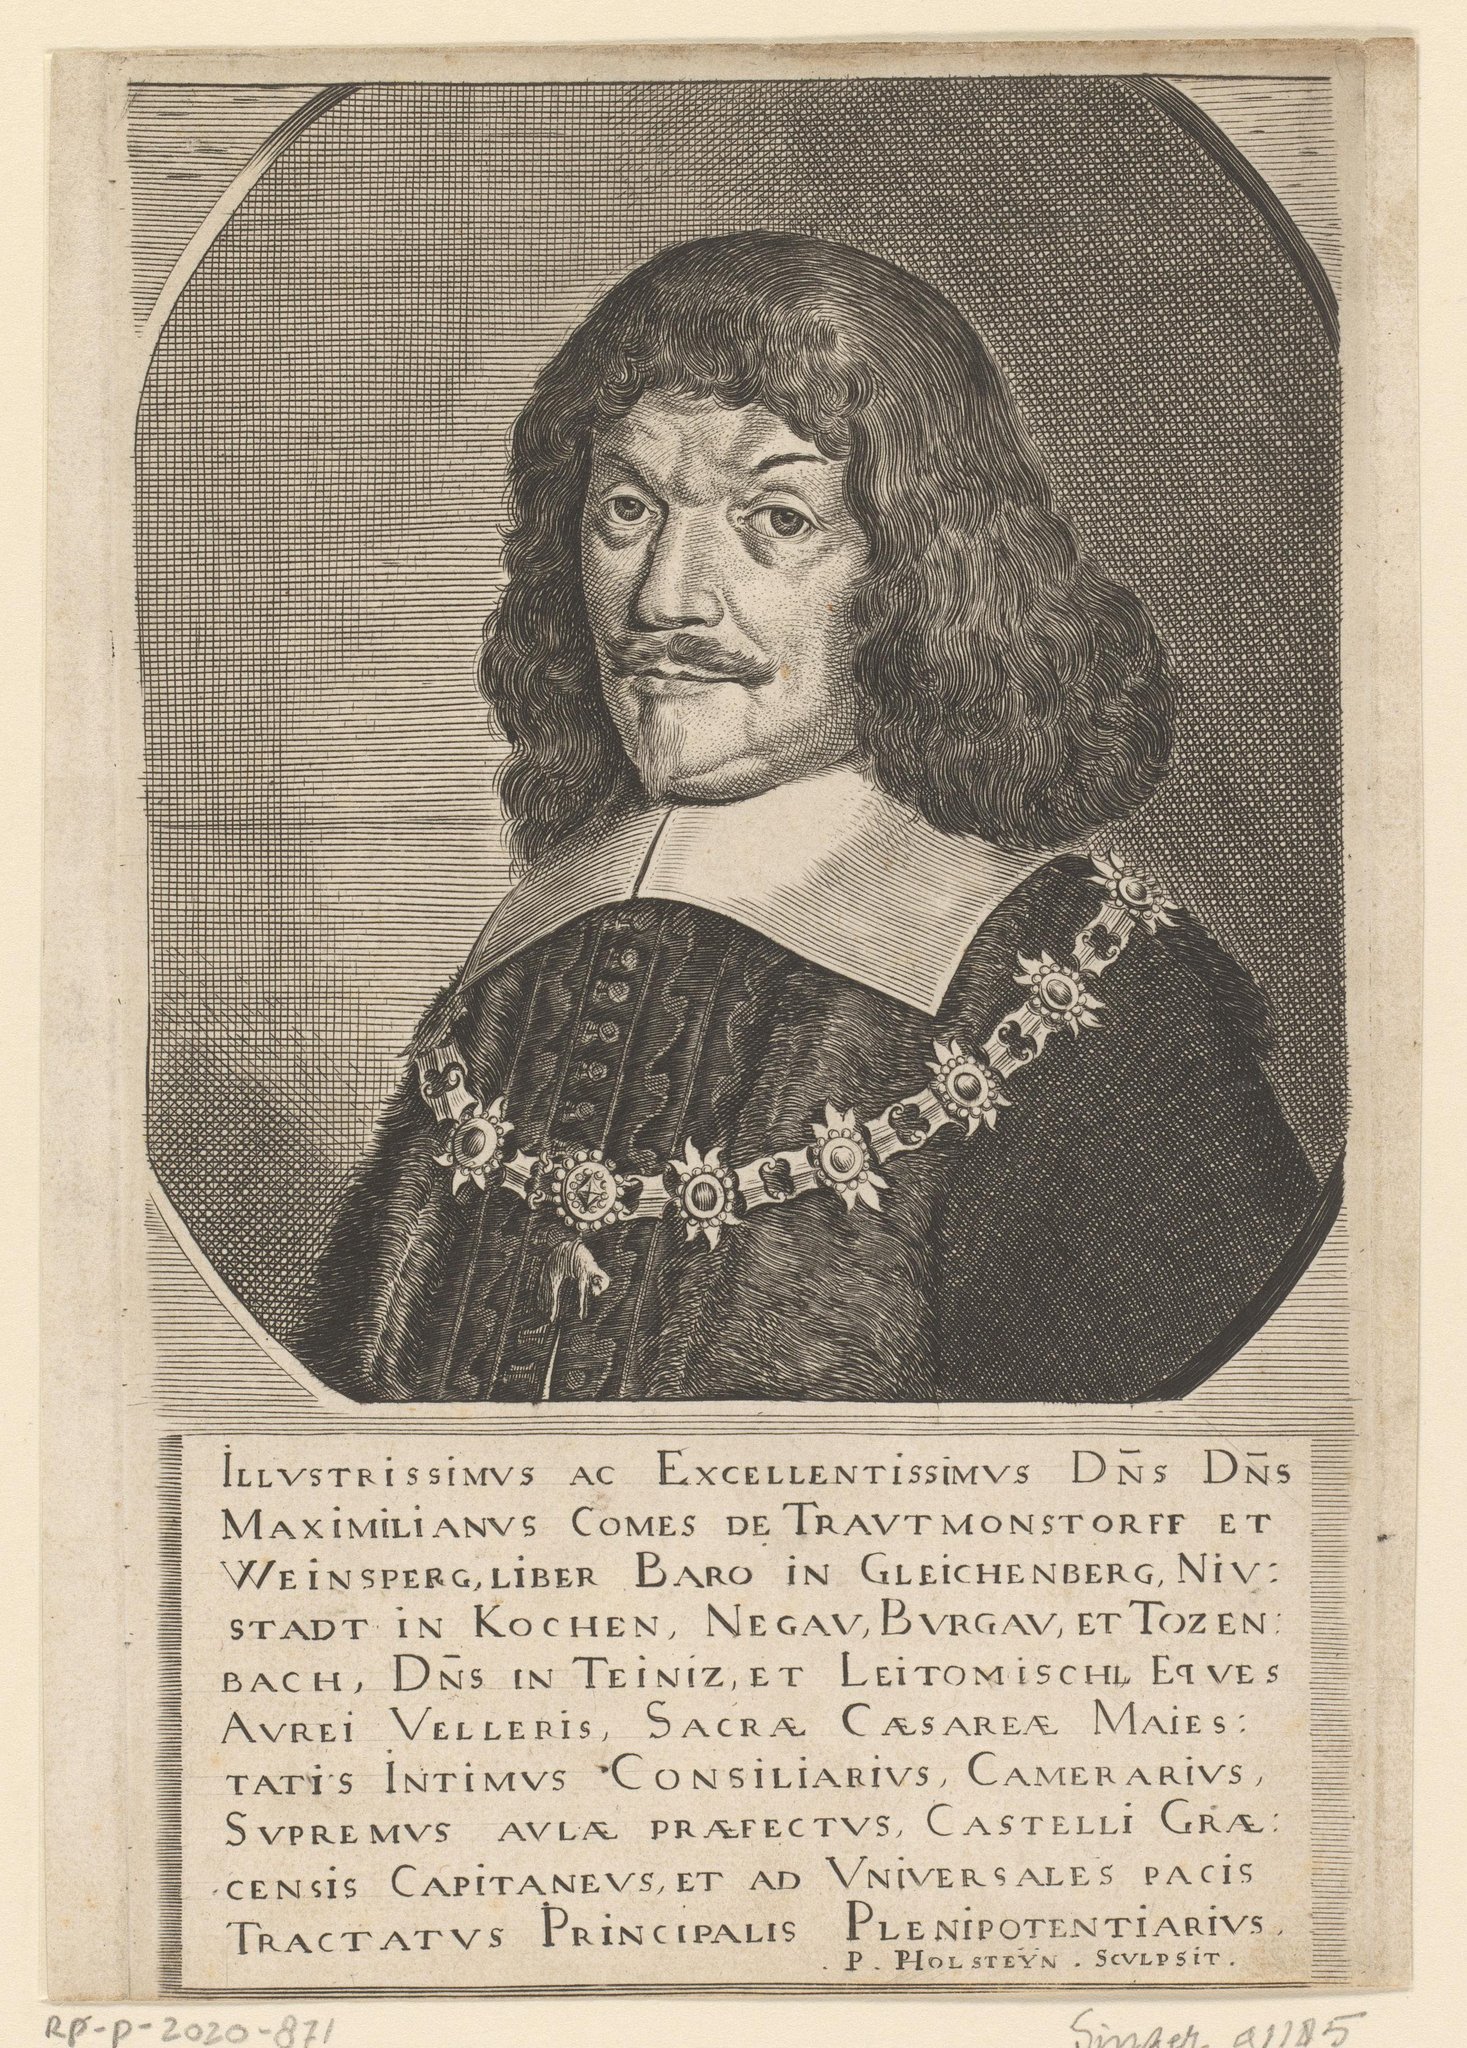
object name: print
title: Portretten van diplomaten en onderhandelaars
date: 1644-1646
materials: paper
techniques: engraving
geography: amsterdam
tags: vienna, official; civil servant; functionary (in general), historical persons, diplomacy, diplomat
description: Prent maakt deel uit van een serie van 43 prenten. Latere staat van prent gebruikt in de serie 'Pacificatores orbis Christiani in Westphaliam missi anno 1641', uitgegeven door Rombout van den Hoeye in Amsterdam.